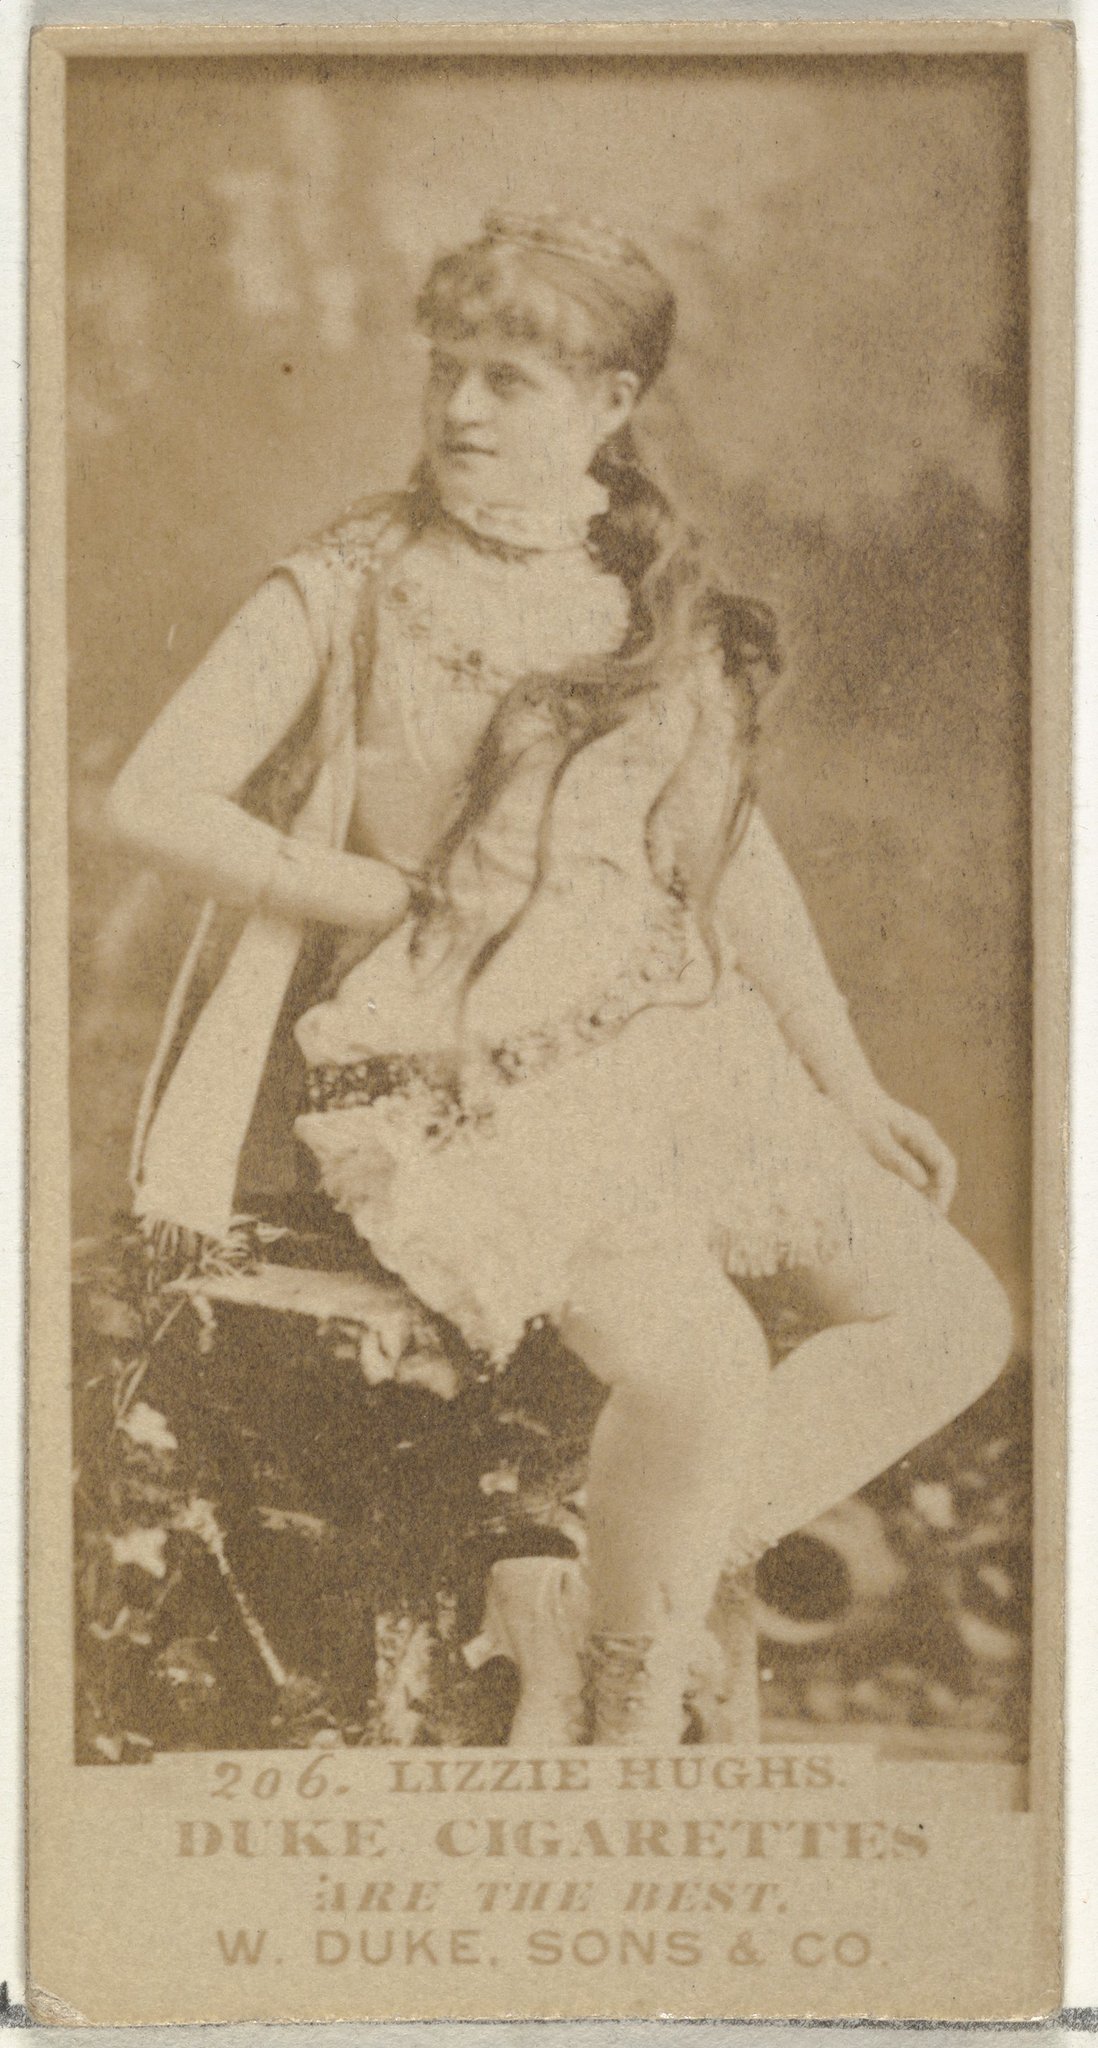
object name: photograph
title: Card Number 206, Lizzie Hughs, from the Actors and Actresses series (N145-7) issued by Duke Sons & Co. to promote Duke Cigarettes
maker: w. duke, sons & co.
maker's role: publisher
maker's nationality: american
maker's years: 1870-1920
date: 1880-1889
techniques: albumen silver print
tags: portraits,women,actresses